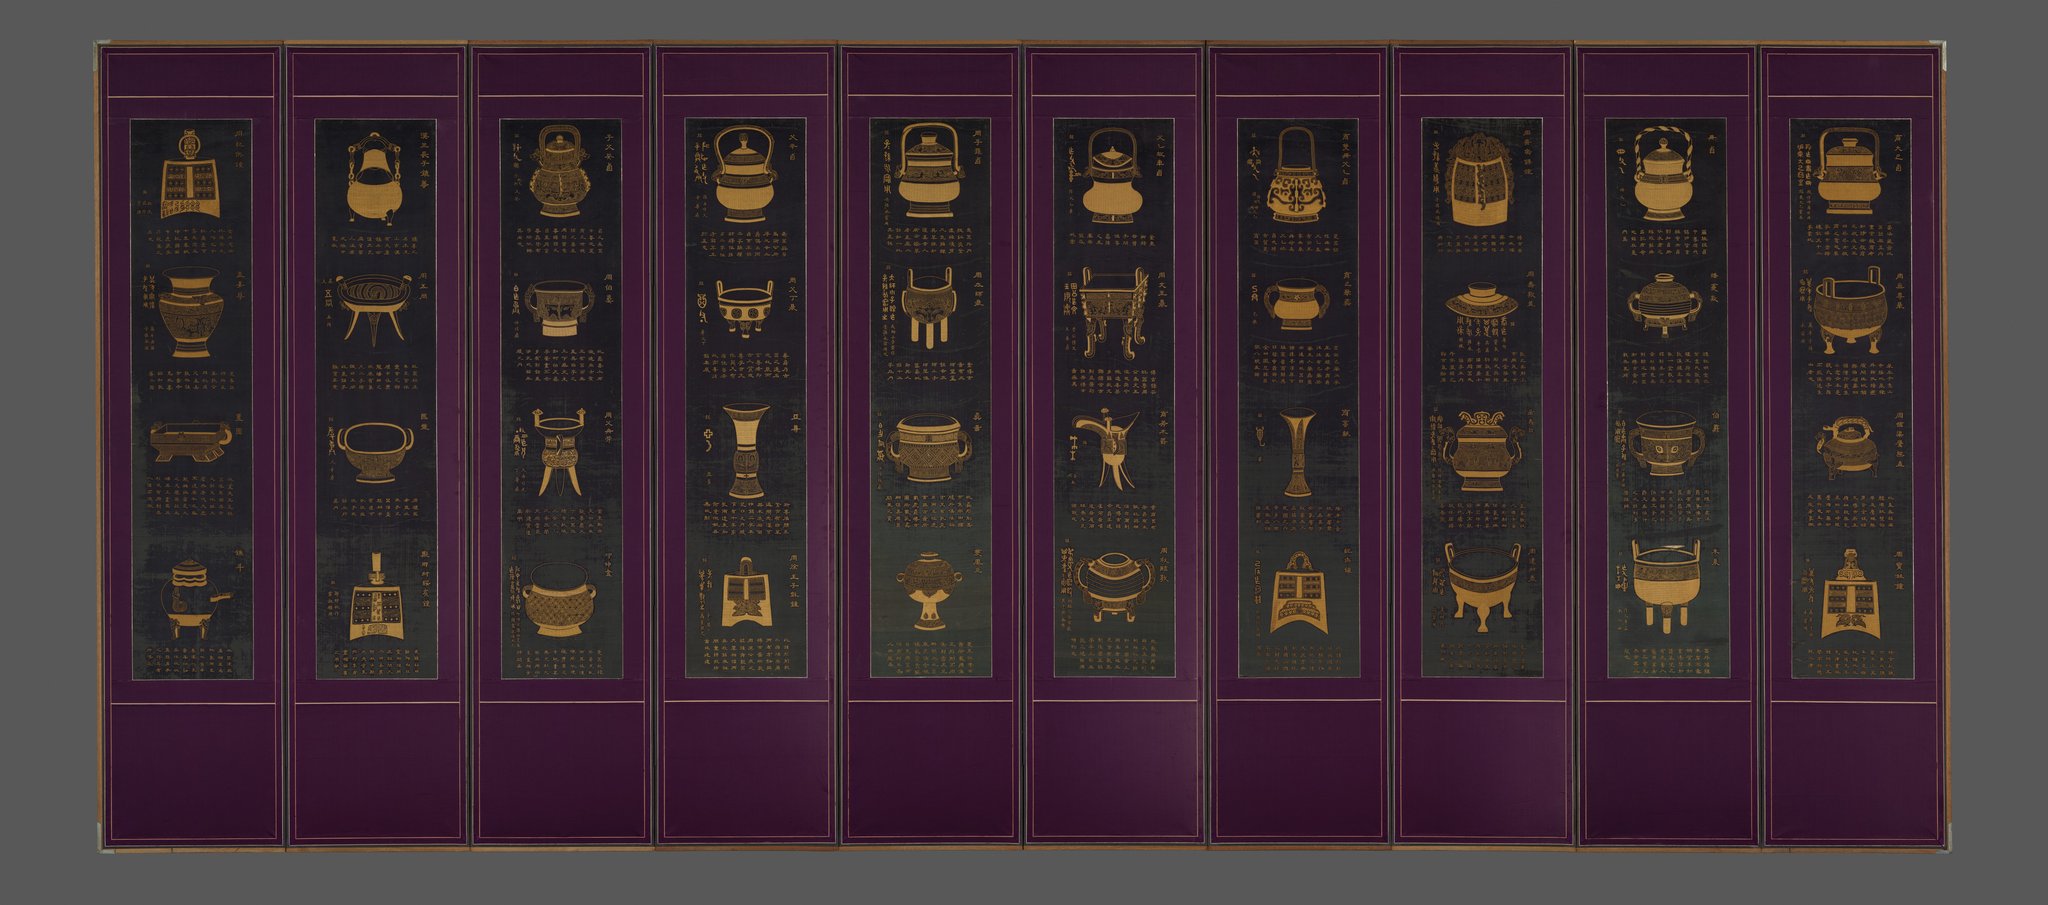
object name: screen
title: Ancient Ritual Bronzes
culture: korean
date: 1867-1900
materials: gold, panel, textile, silk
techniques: embroidery